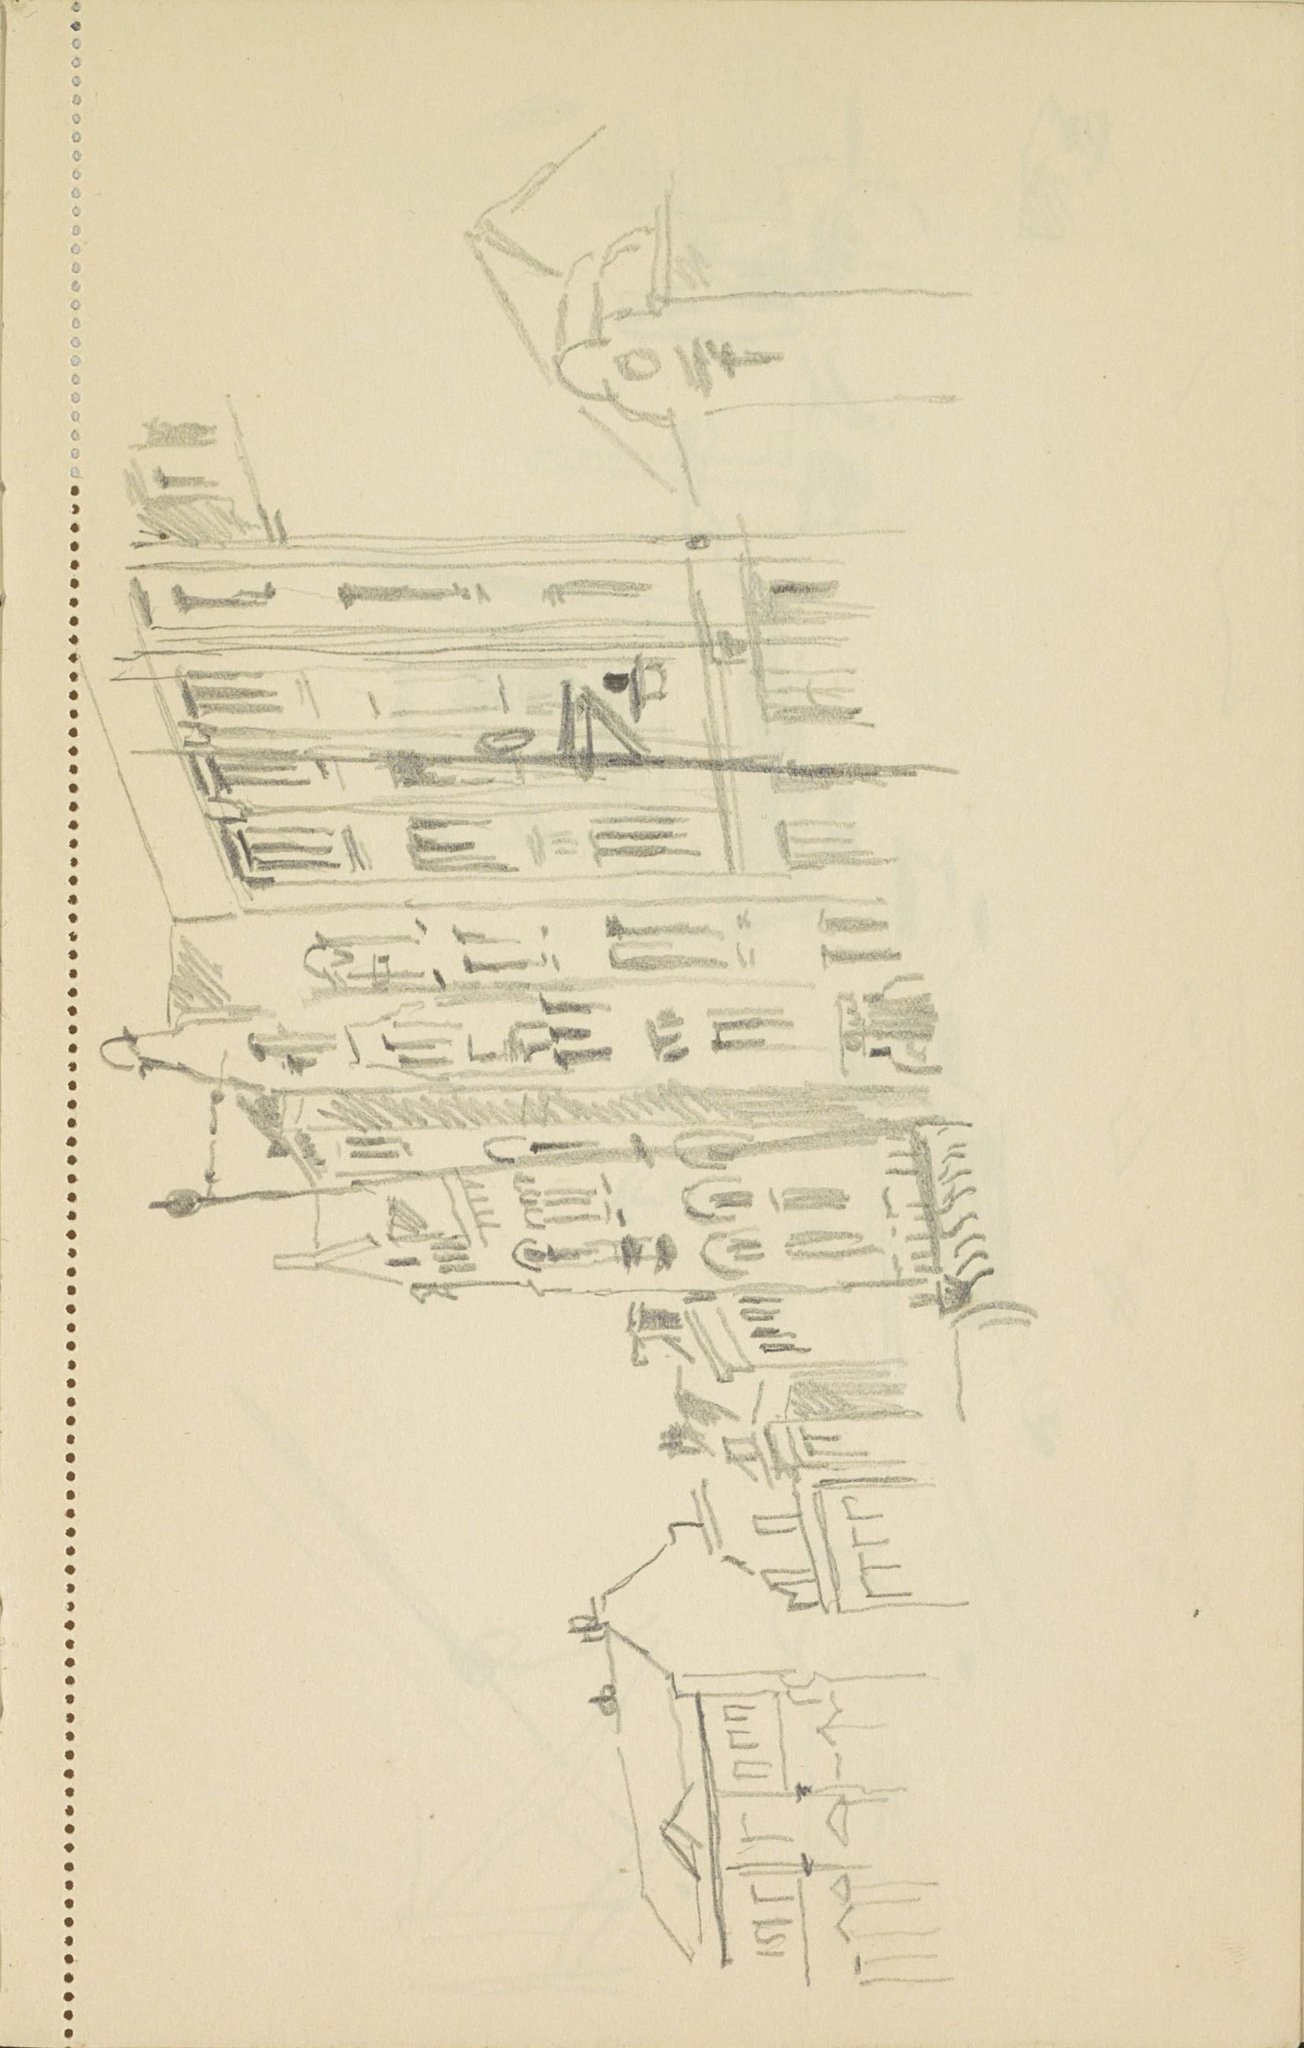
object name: sketchbook leaf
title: Gevels van gebouwen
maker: cornelis vreedenburgh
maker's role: draughtsman, print maker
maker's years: 1880-1946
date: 1890-1946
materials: paper, pencil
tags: façade (of house or building)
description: Blad 8 recto uit een schetsboek met 73 bladen.